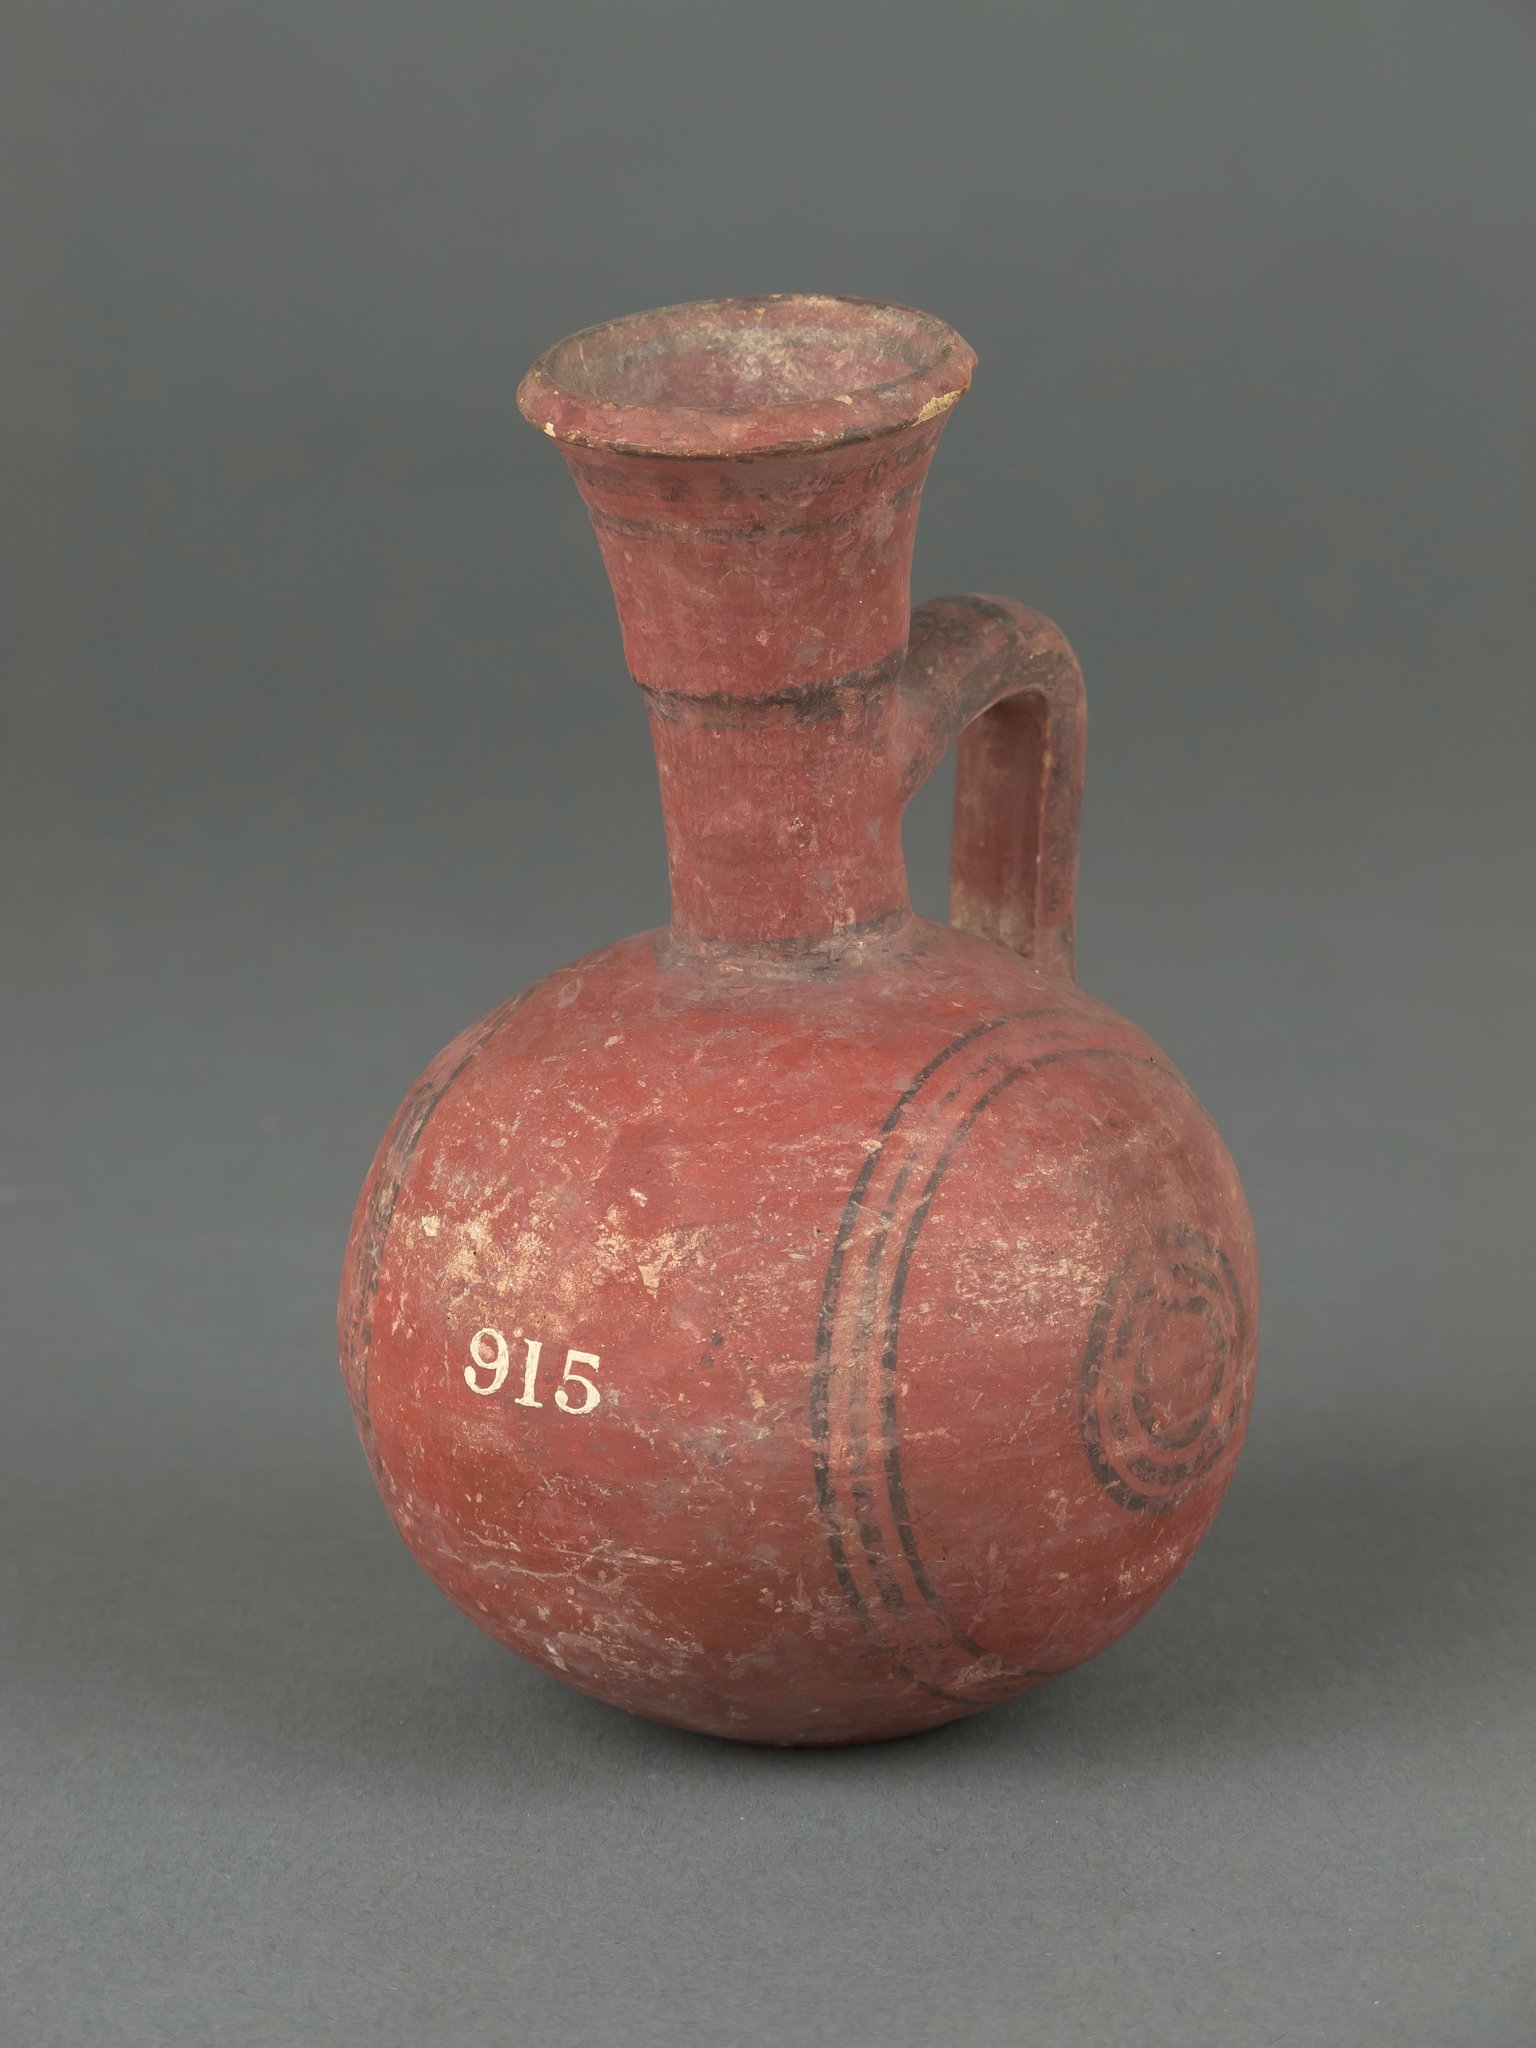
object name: juglet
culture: cypriot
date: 750-600 BCE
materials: terracotta